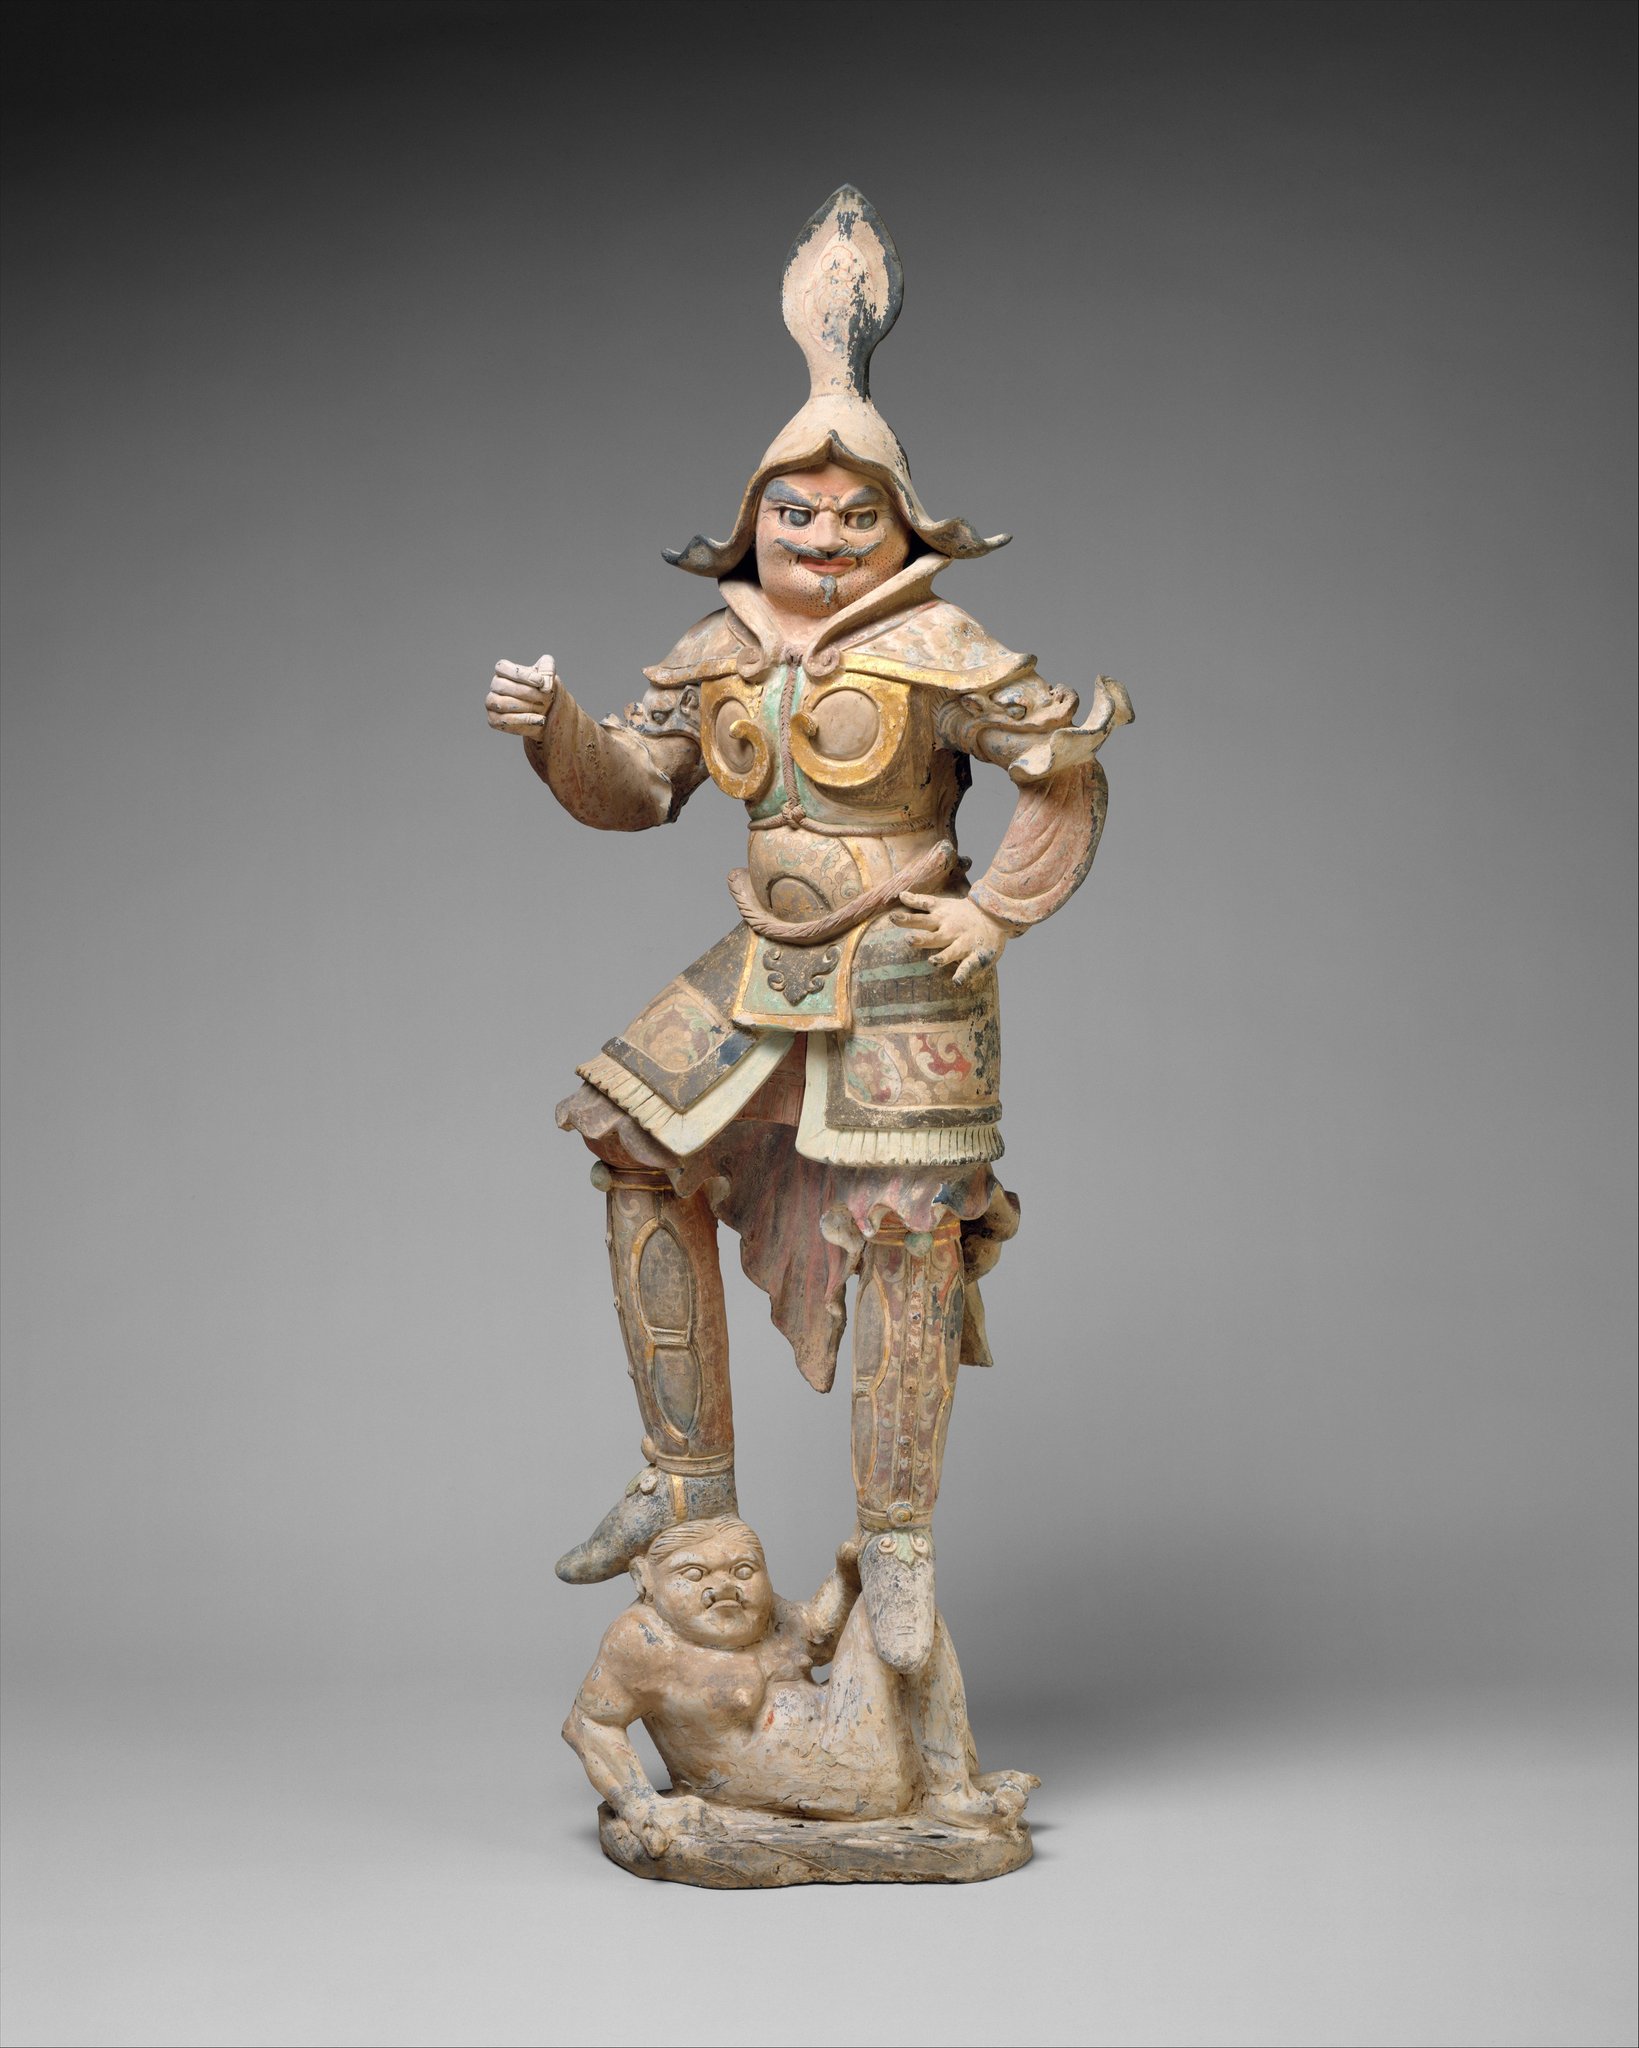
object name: figure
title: Tomb guardian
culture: chinese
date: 701-733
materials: earthenware, pigment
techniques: gilding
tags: men